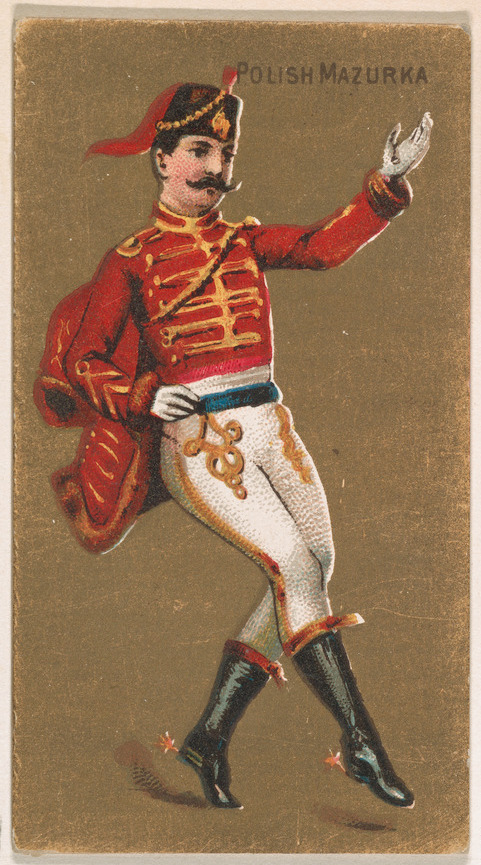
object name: print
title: Polish Mazurka, from National Dances (N225, Type 2) issued by Kinney Bros.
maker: kinney brothers tobacco company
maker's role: publisher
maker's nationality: american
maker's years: 1869-2011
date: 1889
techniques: color lithograph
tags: men,dancing